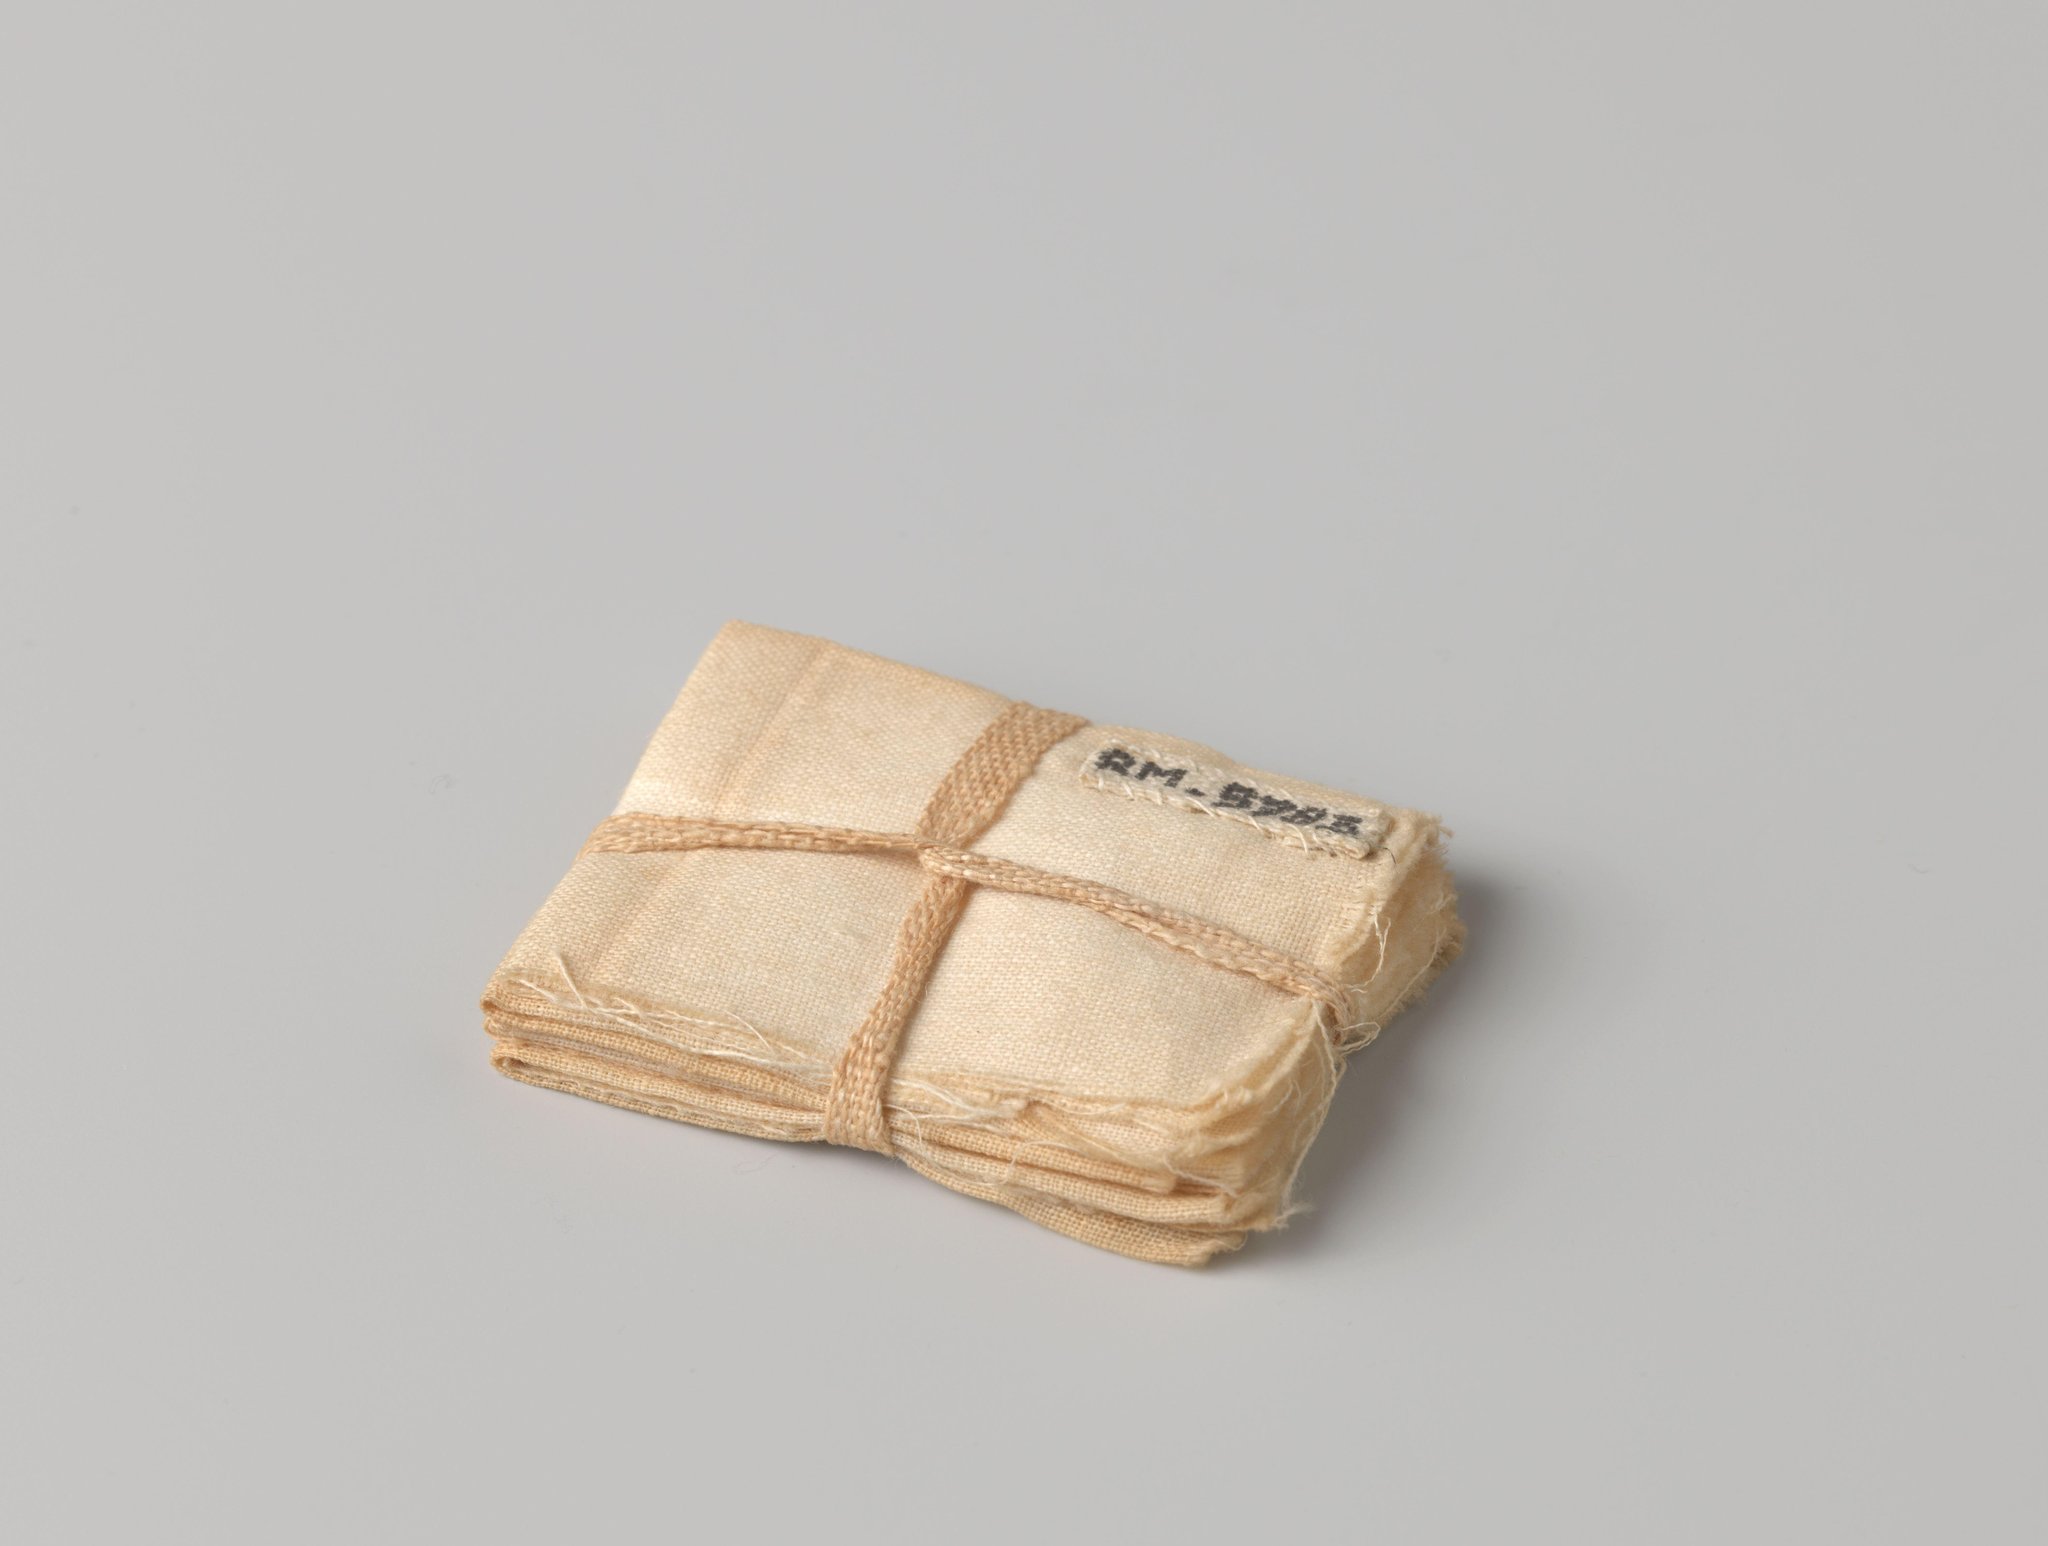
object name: miniature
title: Stapel lappen, samengebonden met een band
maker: Anonymous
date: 1750-1800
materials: cotton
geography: netherlands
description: Een stapel van zes katoenen lappen, opgevouwen en met linnenband samengebonden.